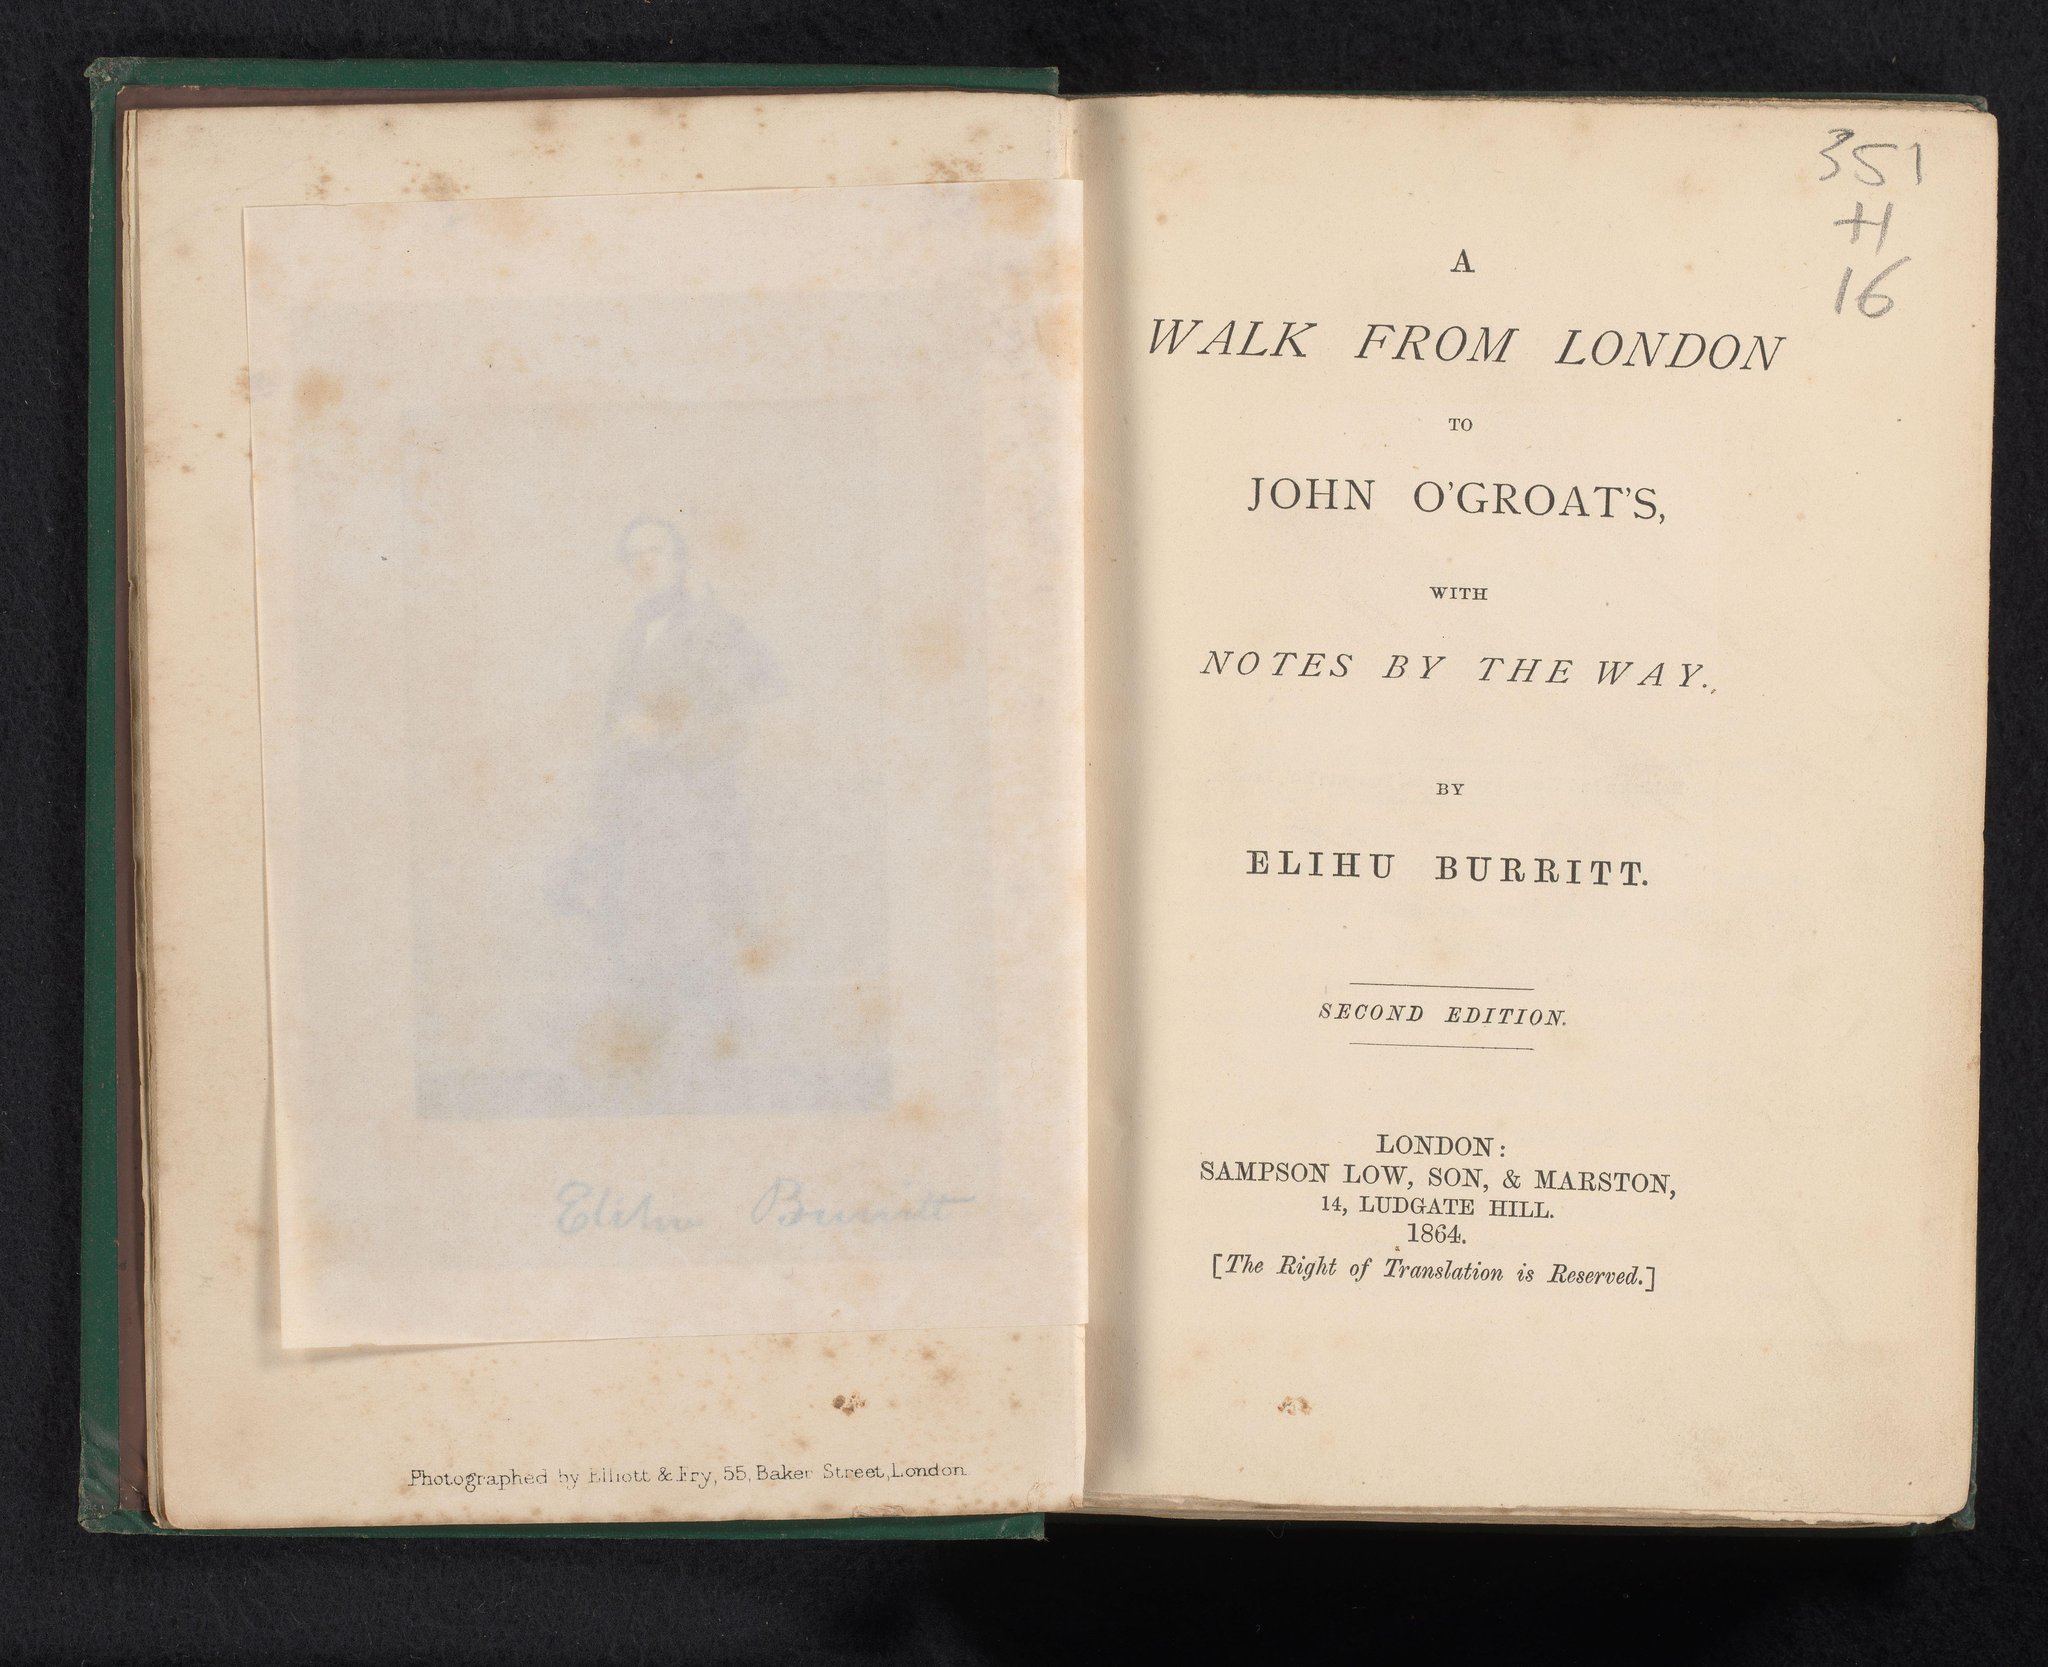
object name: book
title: A walk from London to John O'Groat's, with notes by the way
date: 1864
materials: cardboard, paper, linen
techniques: albumen print, letterpress printing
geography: london